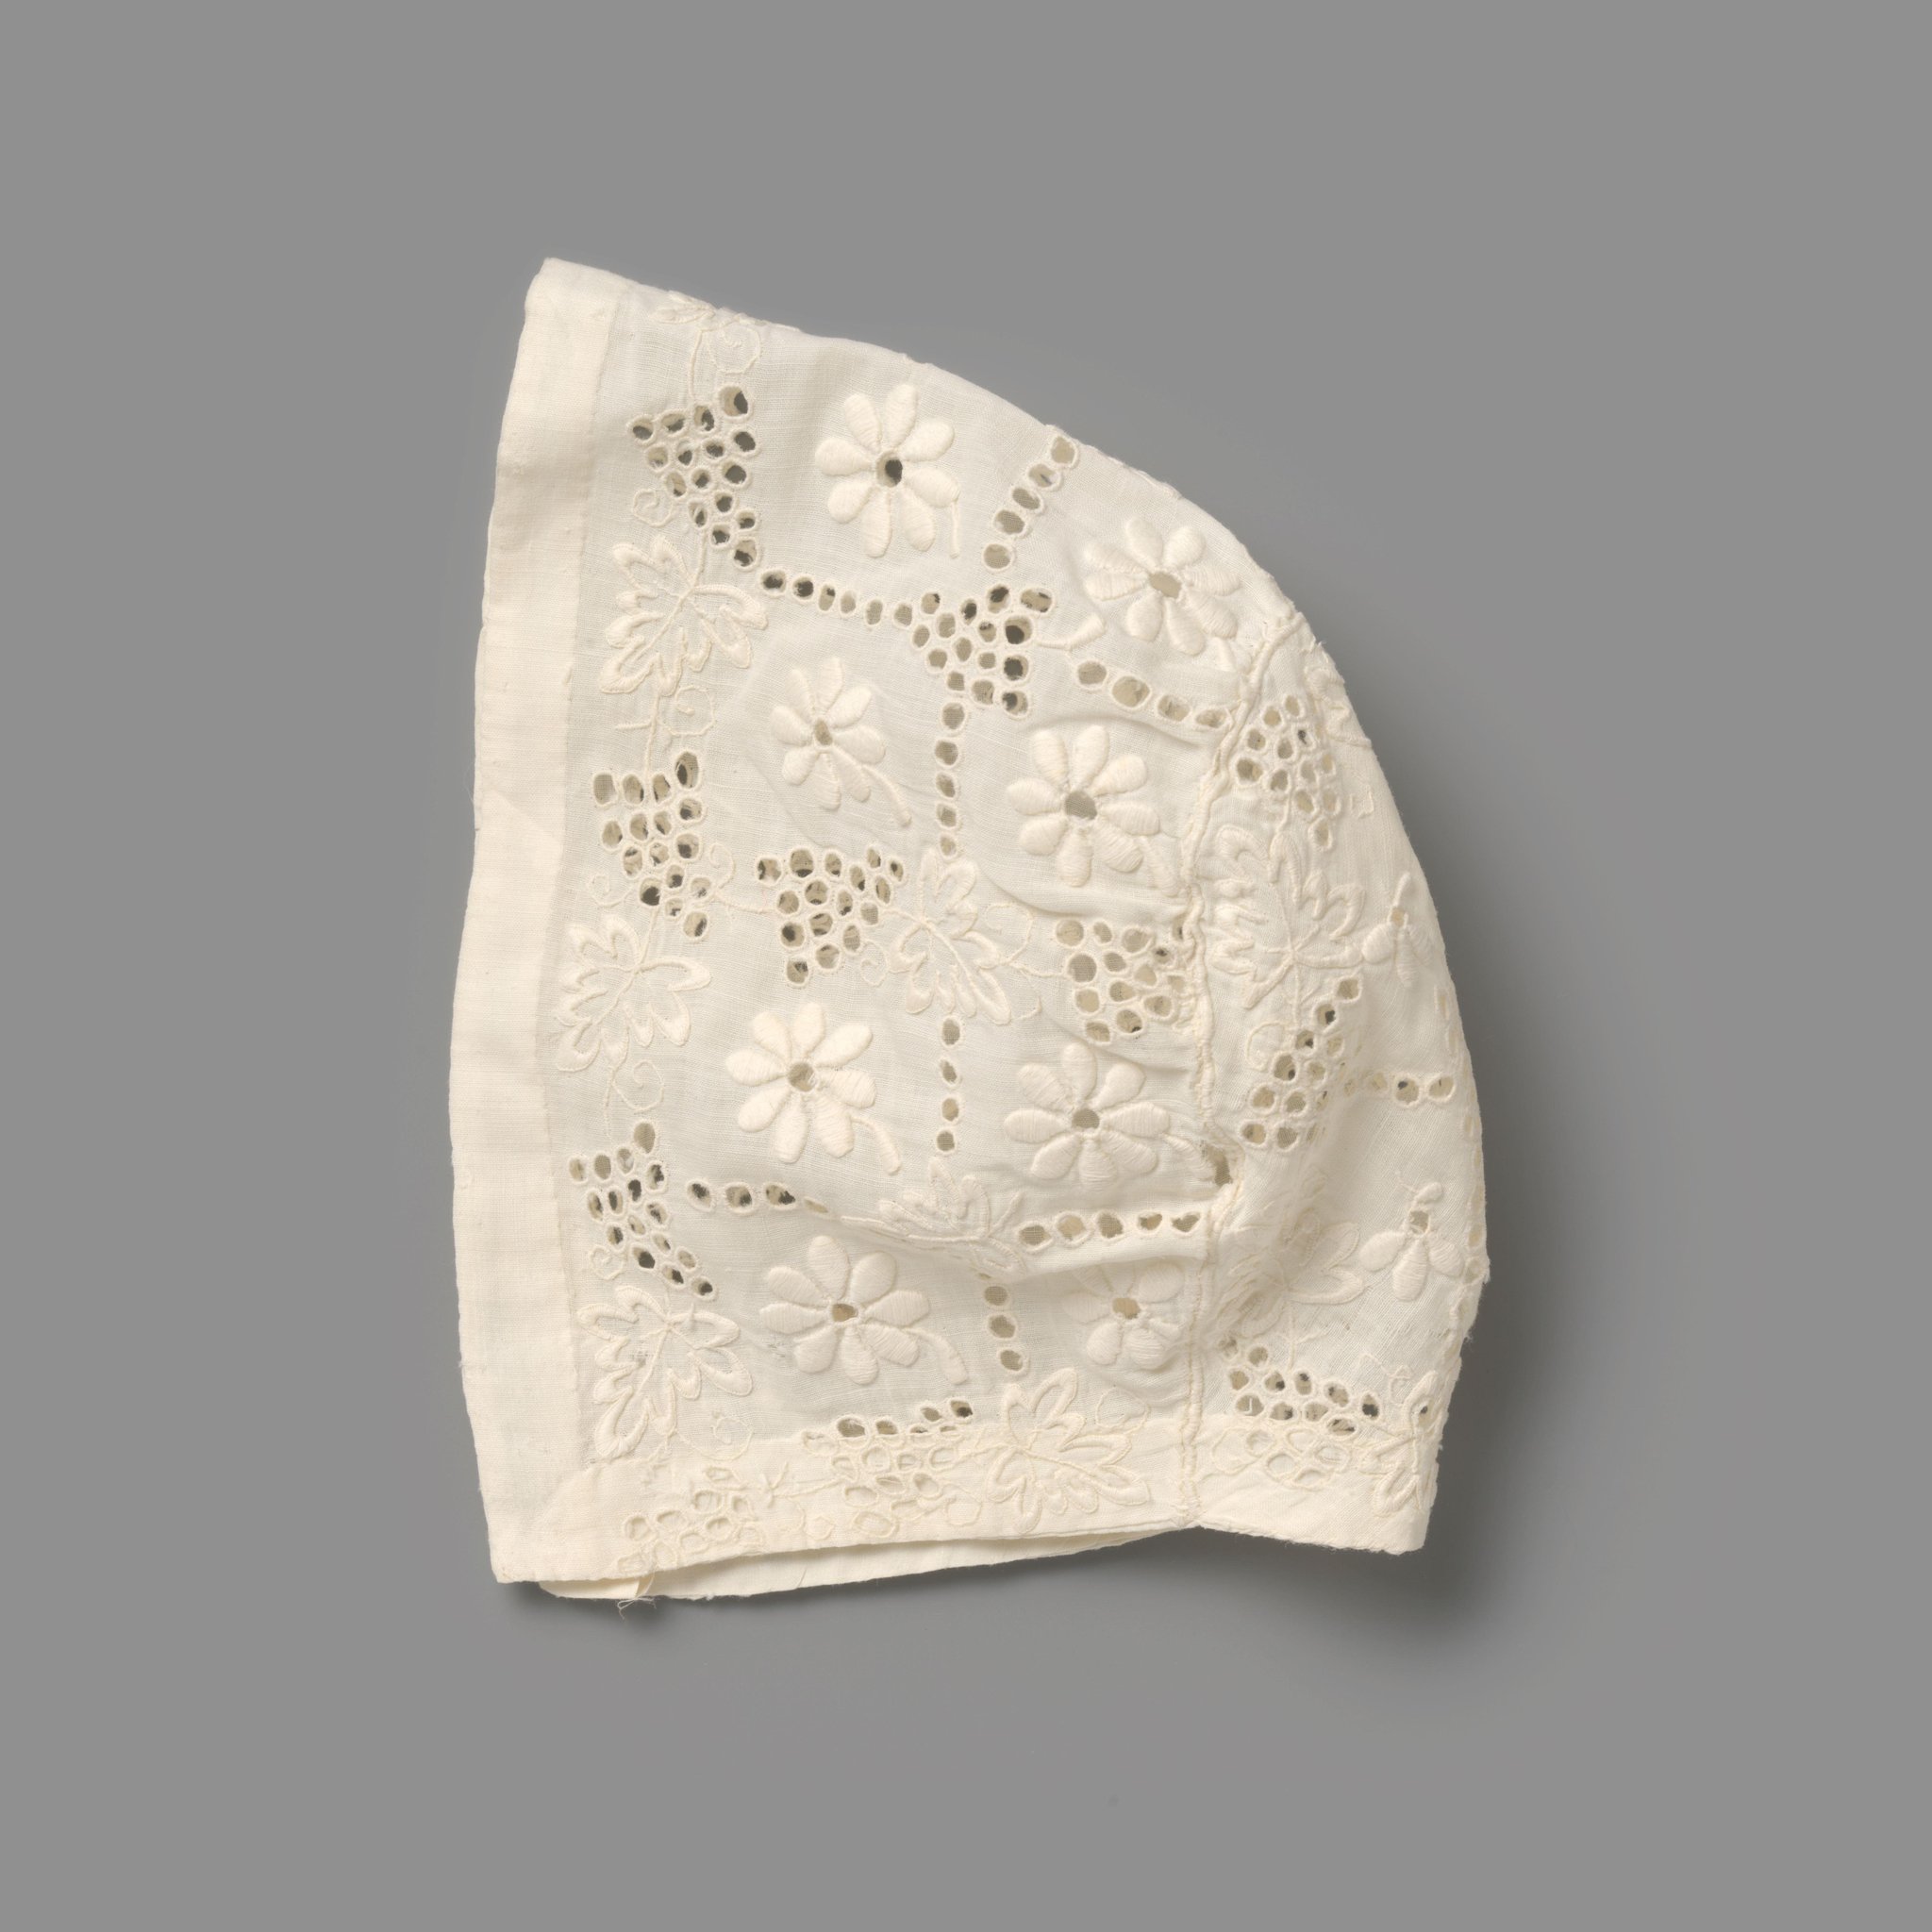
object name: childrenswear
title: Witte katoenen kindermuts met Engels borduurwerk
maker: Anonymous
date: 1850-1870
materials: cotton, textile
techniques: embroidered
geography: netherlands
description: Kindermutsje van vol geborduurde katoen, met hoefijzervormige bol en dwars voorpand(meisje), met een decor van druiventrossn en -bladeren, waartussen rozetbloempjes. Second Empire? Patroon: De druiventrossen zijn van gecordonneerde gaatjes en de blaadjes en bloempjes van festo- en satijnsteek.